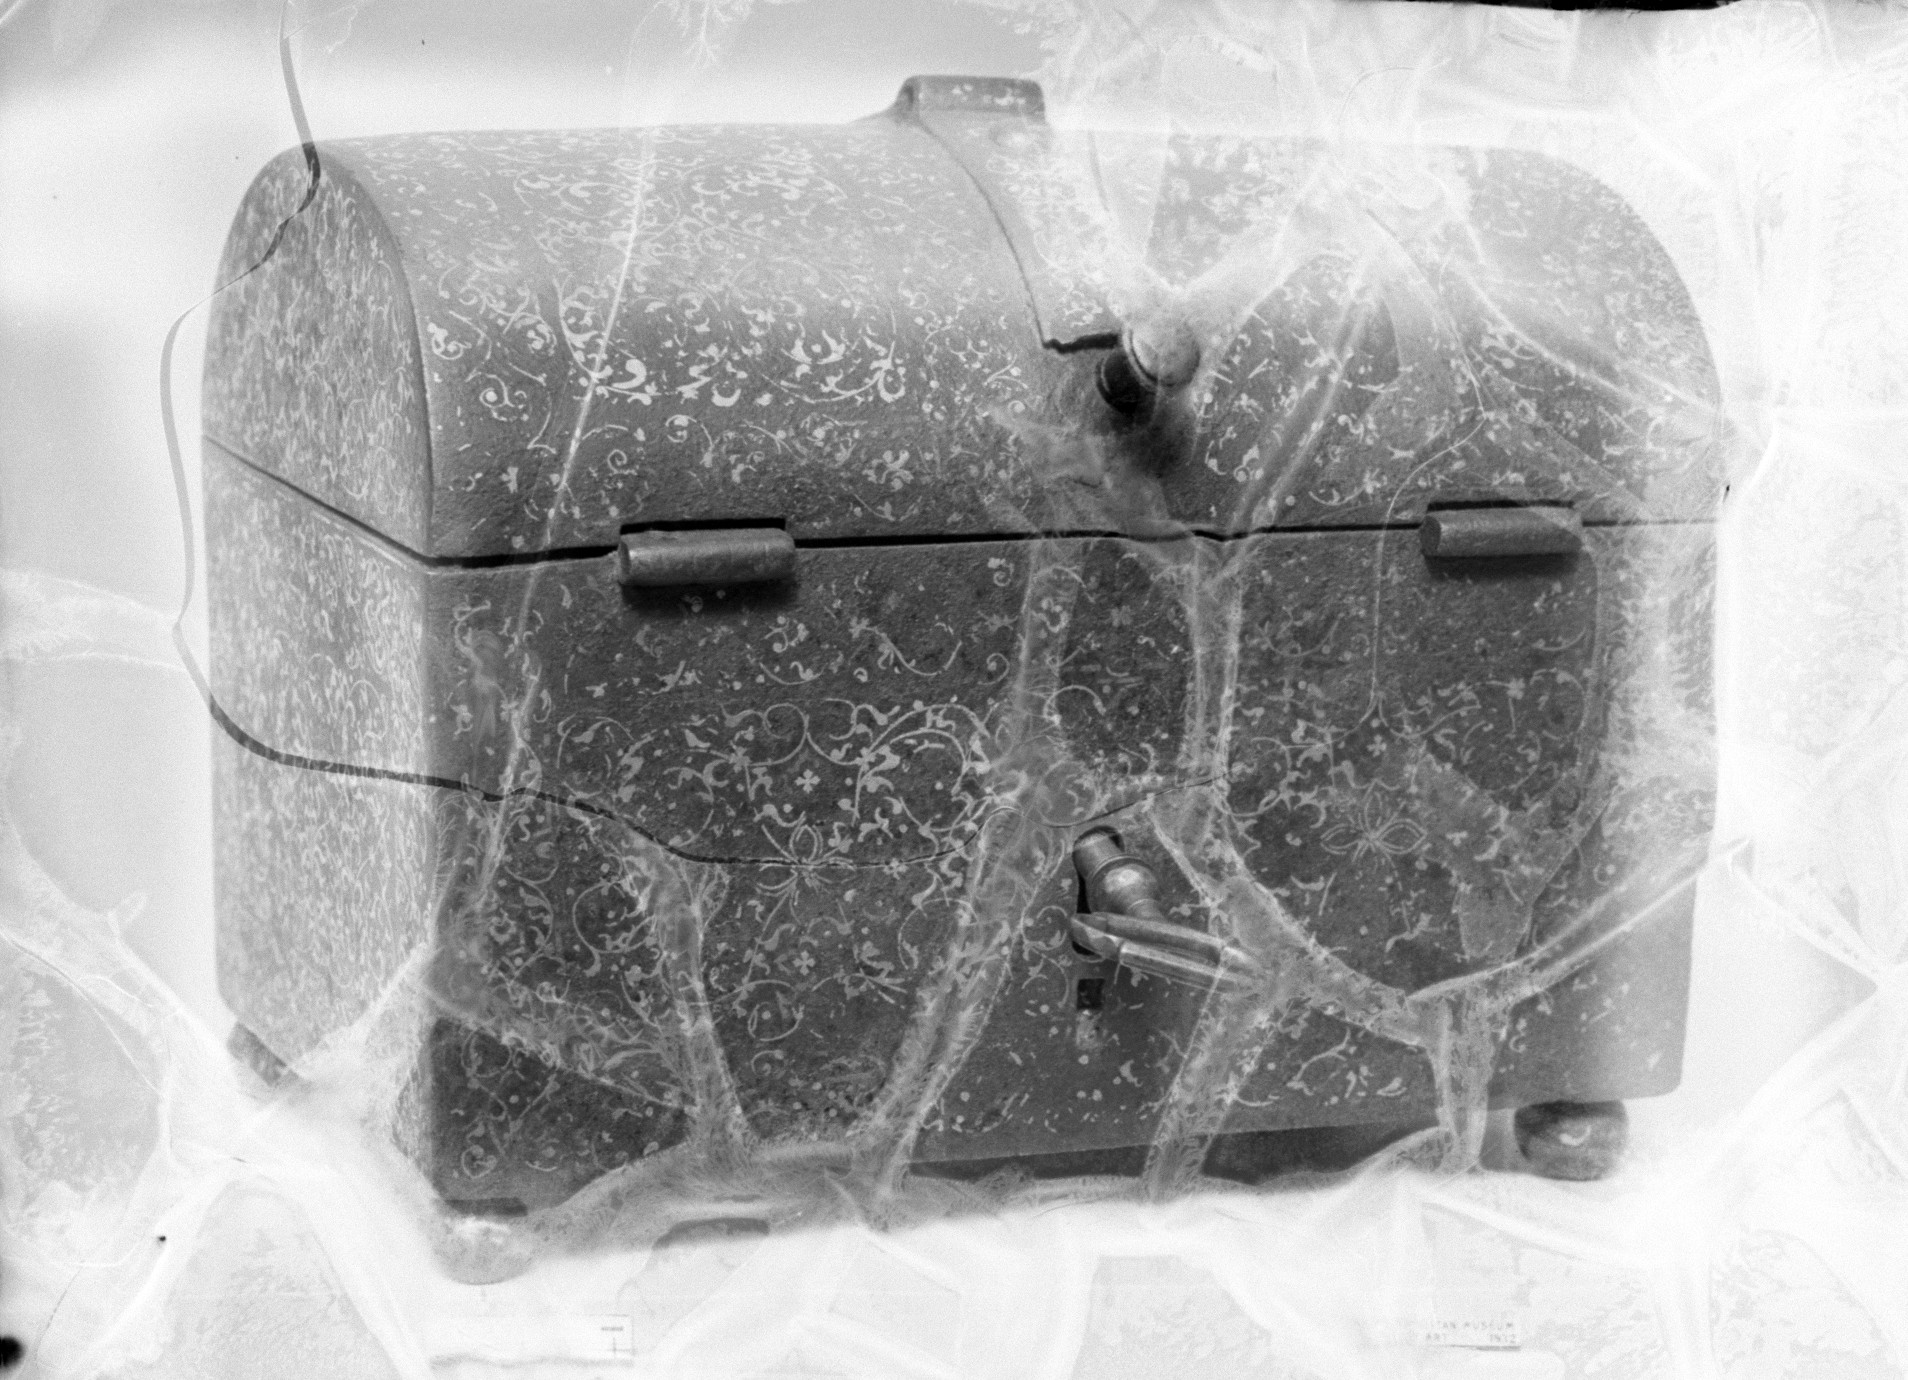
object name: casket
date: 1501-1600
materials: gold, iron, silver